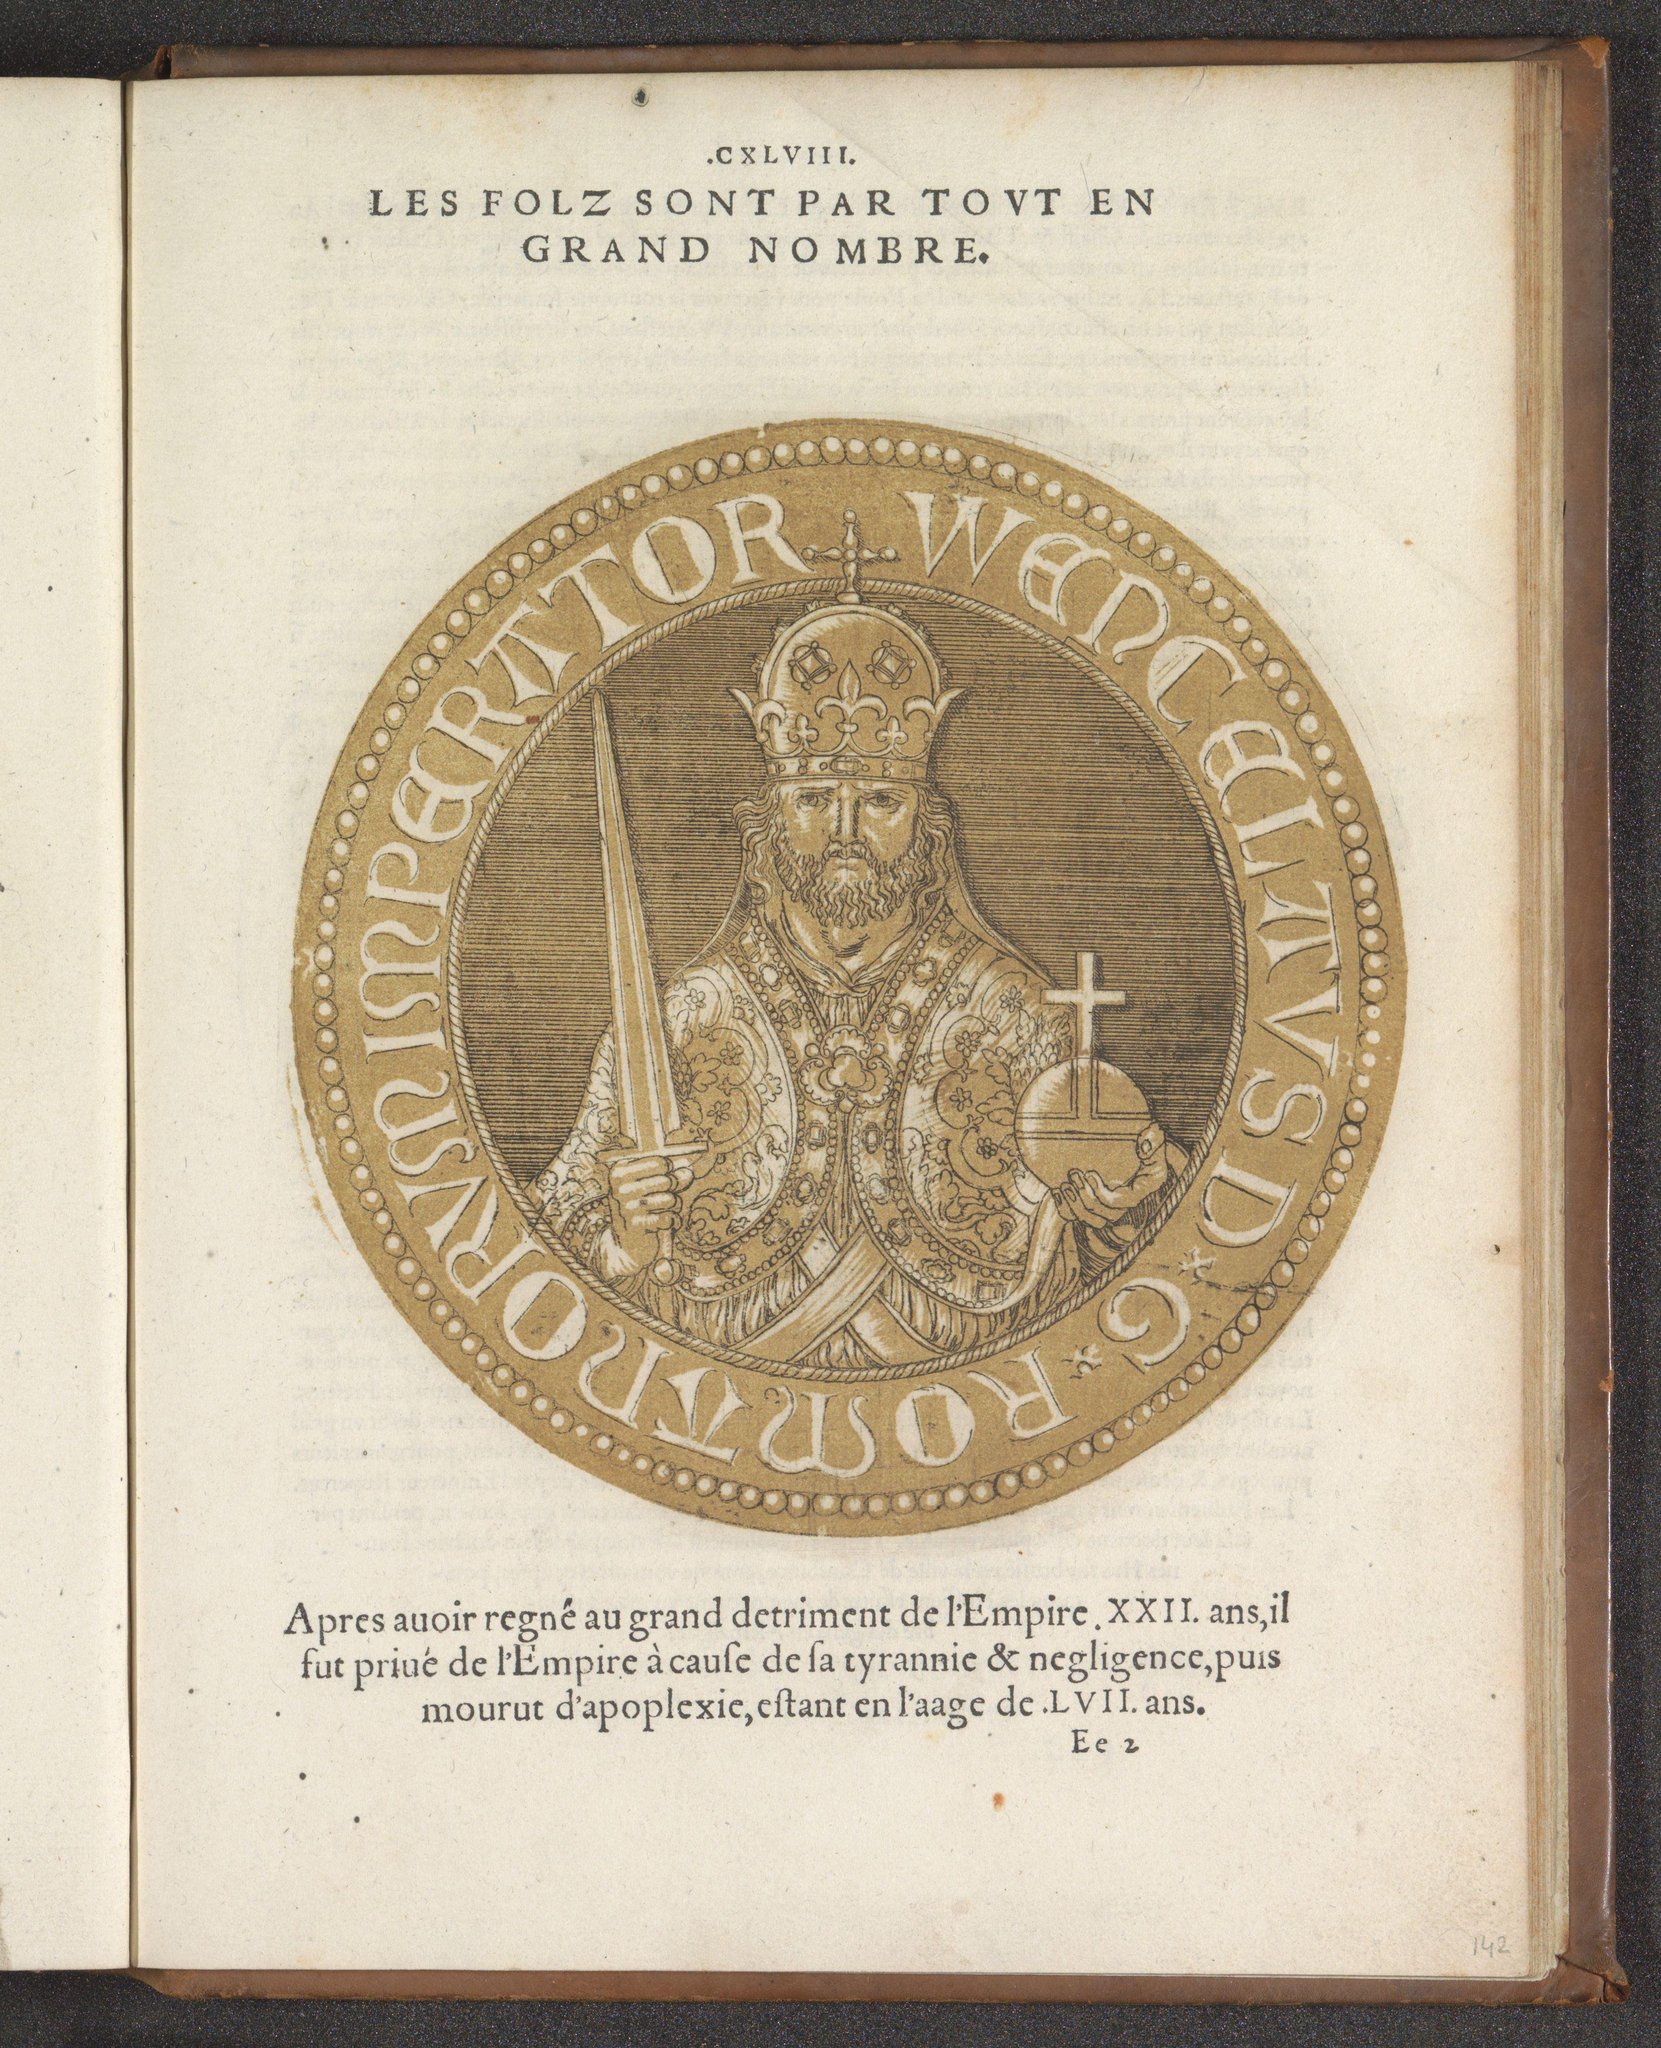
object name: print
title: Portret van rooms-koning Wenceslaus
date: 1557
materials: paper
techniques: woodcut, etching, letterpress printing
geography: antwerp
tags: prague, emperor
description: Portret van rooms-koning Wenceslaus, op een munt met randschrift. De prent maakt deel uit van een boek over de keizers vanaf Julius Caesar tot en met Karel V en zijn broer Ferdinand.